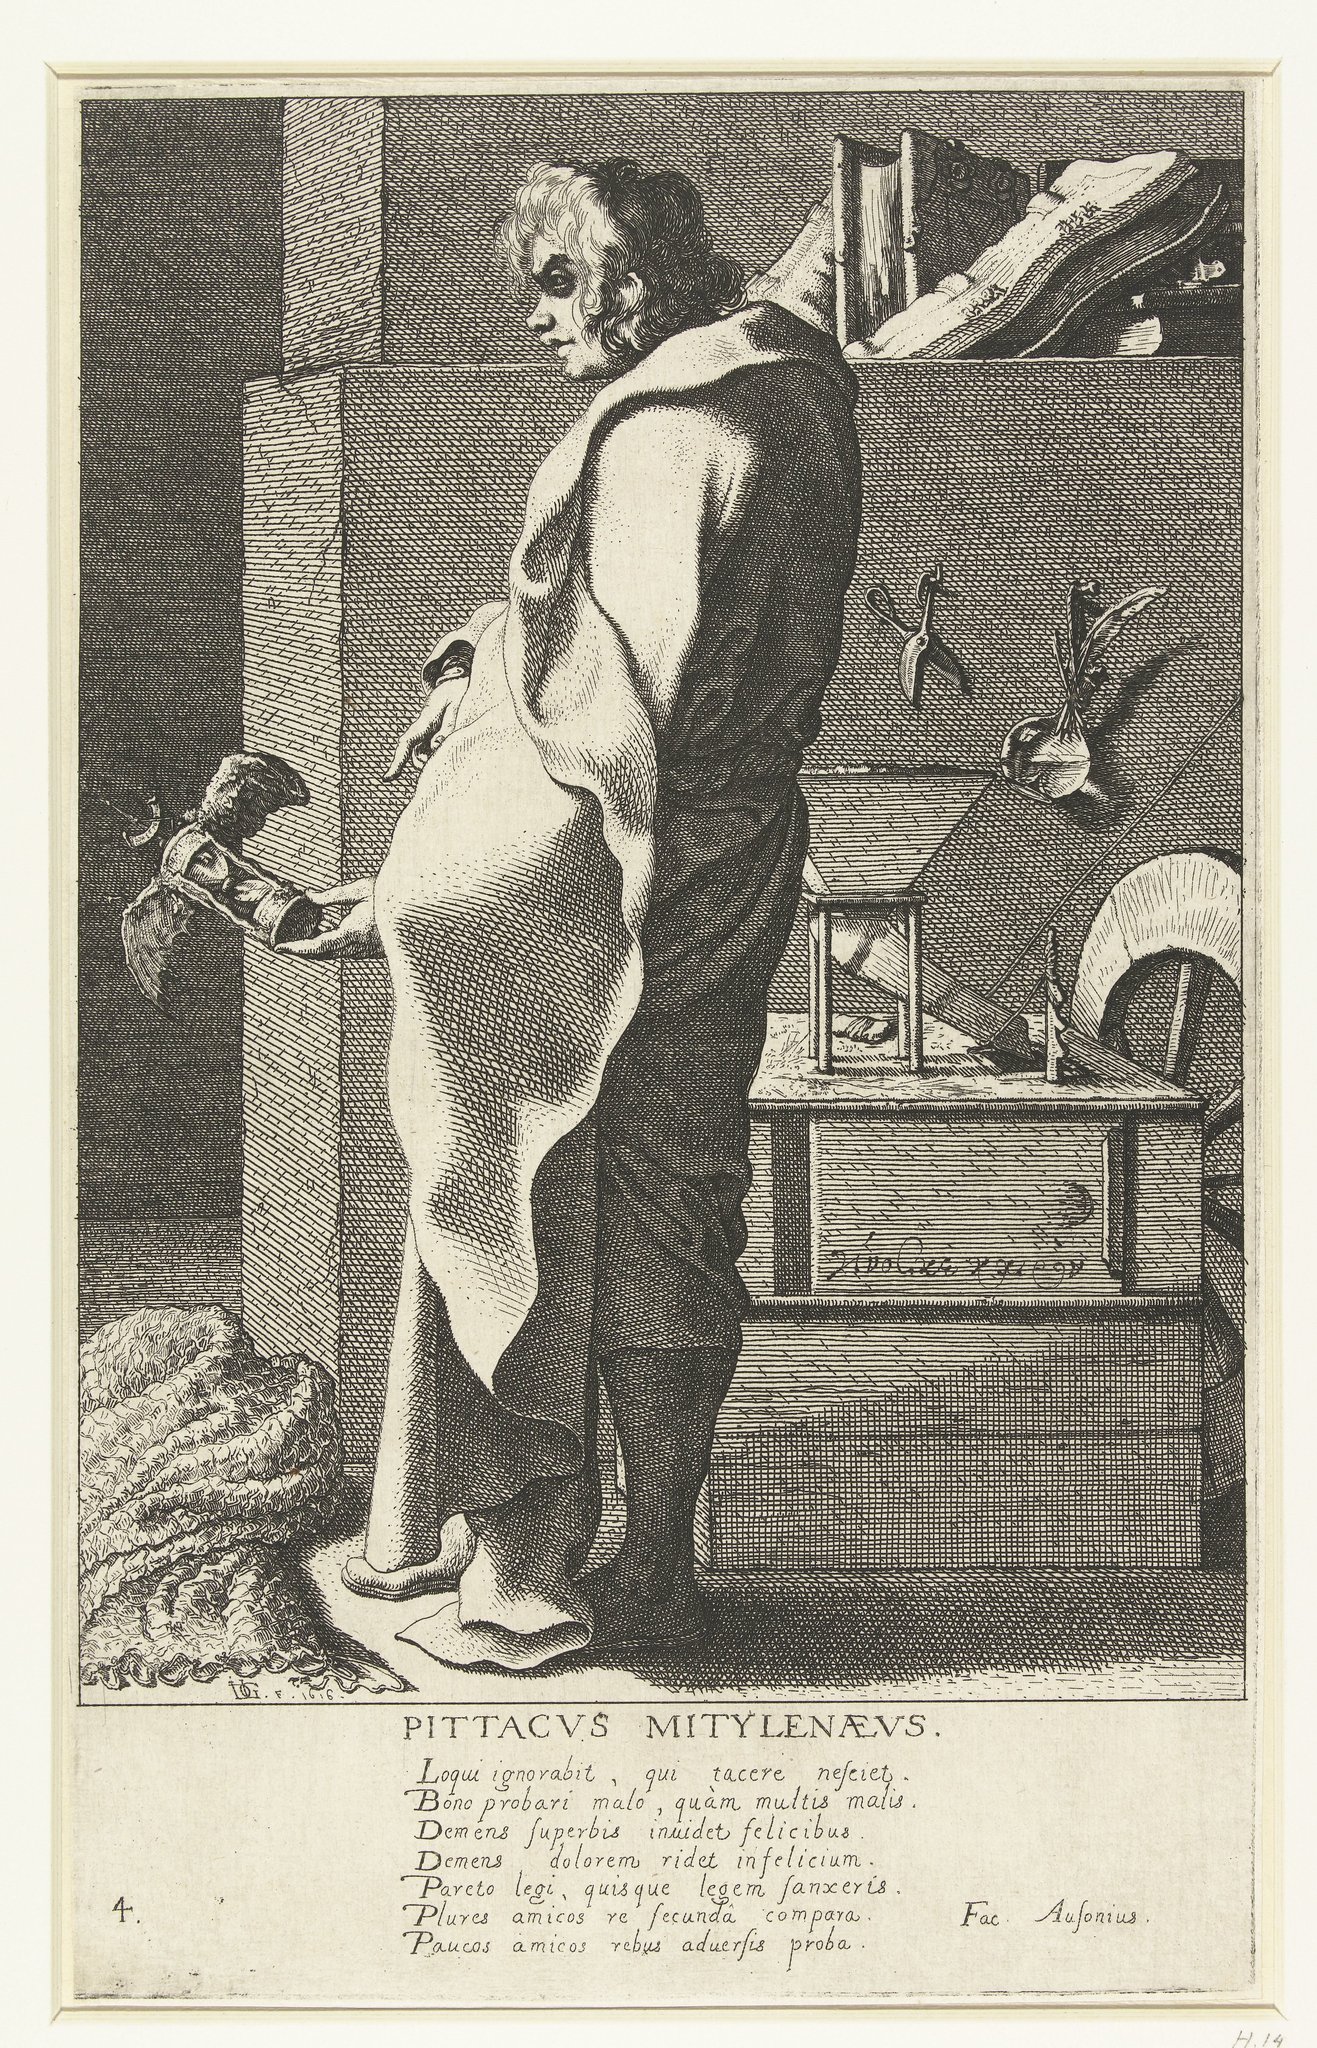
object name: print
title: Pittacus Mitylenaeus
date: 1616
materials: paper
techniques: etching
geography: netherlands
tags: the seven wise men of greece: bias, chilon, cleobulus, periander (alternatively myson), pittacus, solon, thales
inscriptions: collector's mark: Lugt 2228a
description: Een man gekleed in een lange mantel, ten voeten uit, op de linkerzijde gezien, met de rechterhand wijzend op een gevleugelde zandloper in de linkerhand. Achter hem onder andere een aantal boeken, een schaar, en een werktuig met een trechter en een wiel eraan. Onder de voorstelling een zevenregelig Latijns gedicht. Deze prent is onderdeel van een serie van acht prenten: een titelprent en zeven genummerde portretten van Griekse wijzen.